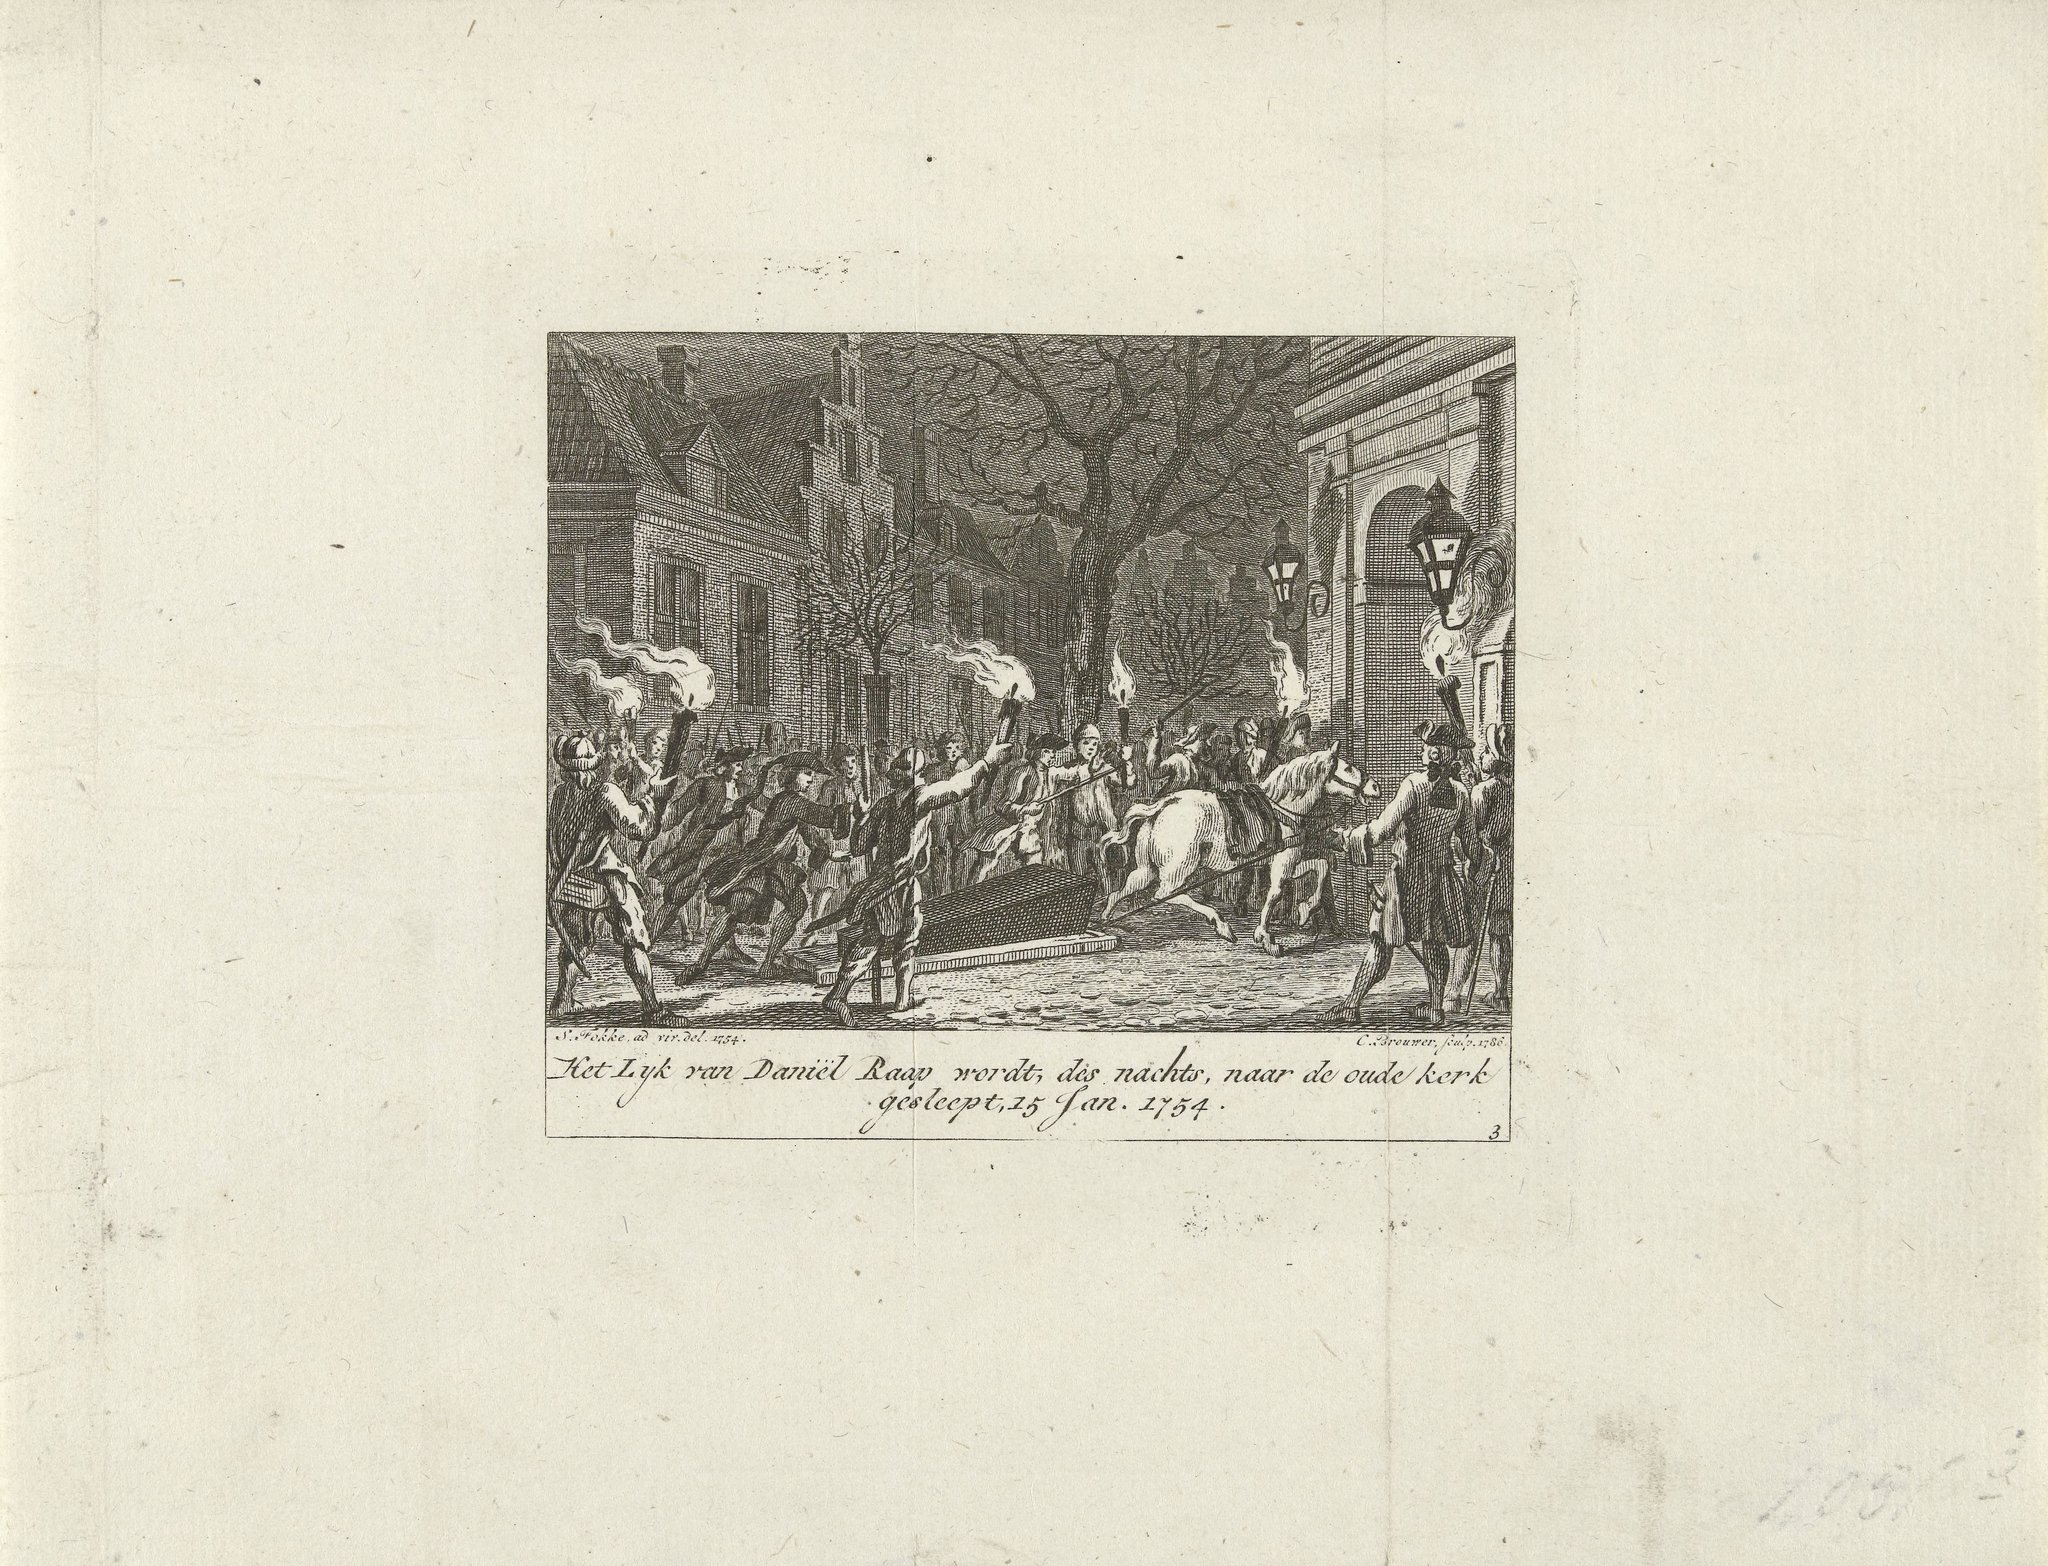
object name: print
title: Doodskist van Daniël Raap wordt 's nachts naar de Oude Kerk overgebracht, 1754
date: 1786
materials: paper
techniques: engraving, etching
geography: northern netherlands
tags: funerary ceremonial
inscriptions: collector's mark: Lugt 2228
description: De doodskist met het lichaam van de koopman en orangist Daniël Raap wordt 's nachts naar de Oude Kerk gesleept, 15 januari 1754. Onderdeel van een groep van vier illustraties van de ongeregeldheden bij de begrafenis van Daniël Raap te Amsterdam. Genummerd rechtsonder: 3.